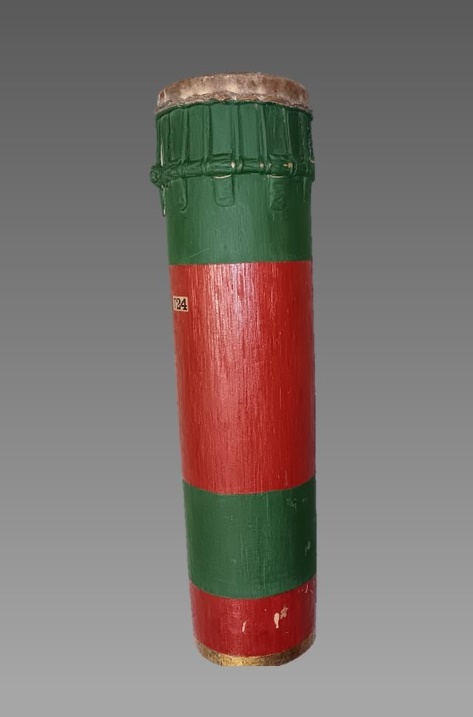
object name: dogdog lojor indung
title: Dogdog lojor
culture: javanese, sunda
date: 1867-1900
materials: fiber, wood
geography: indonesia